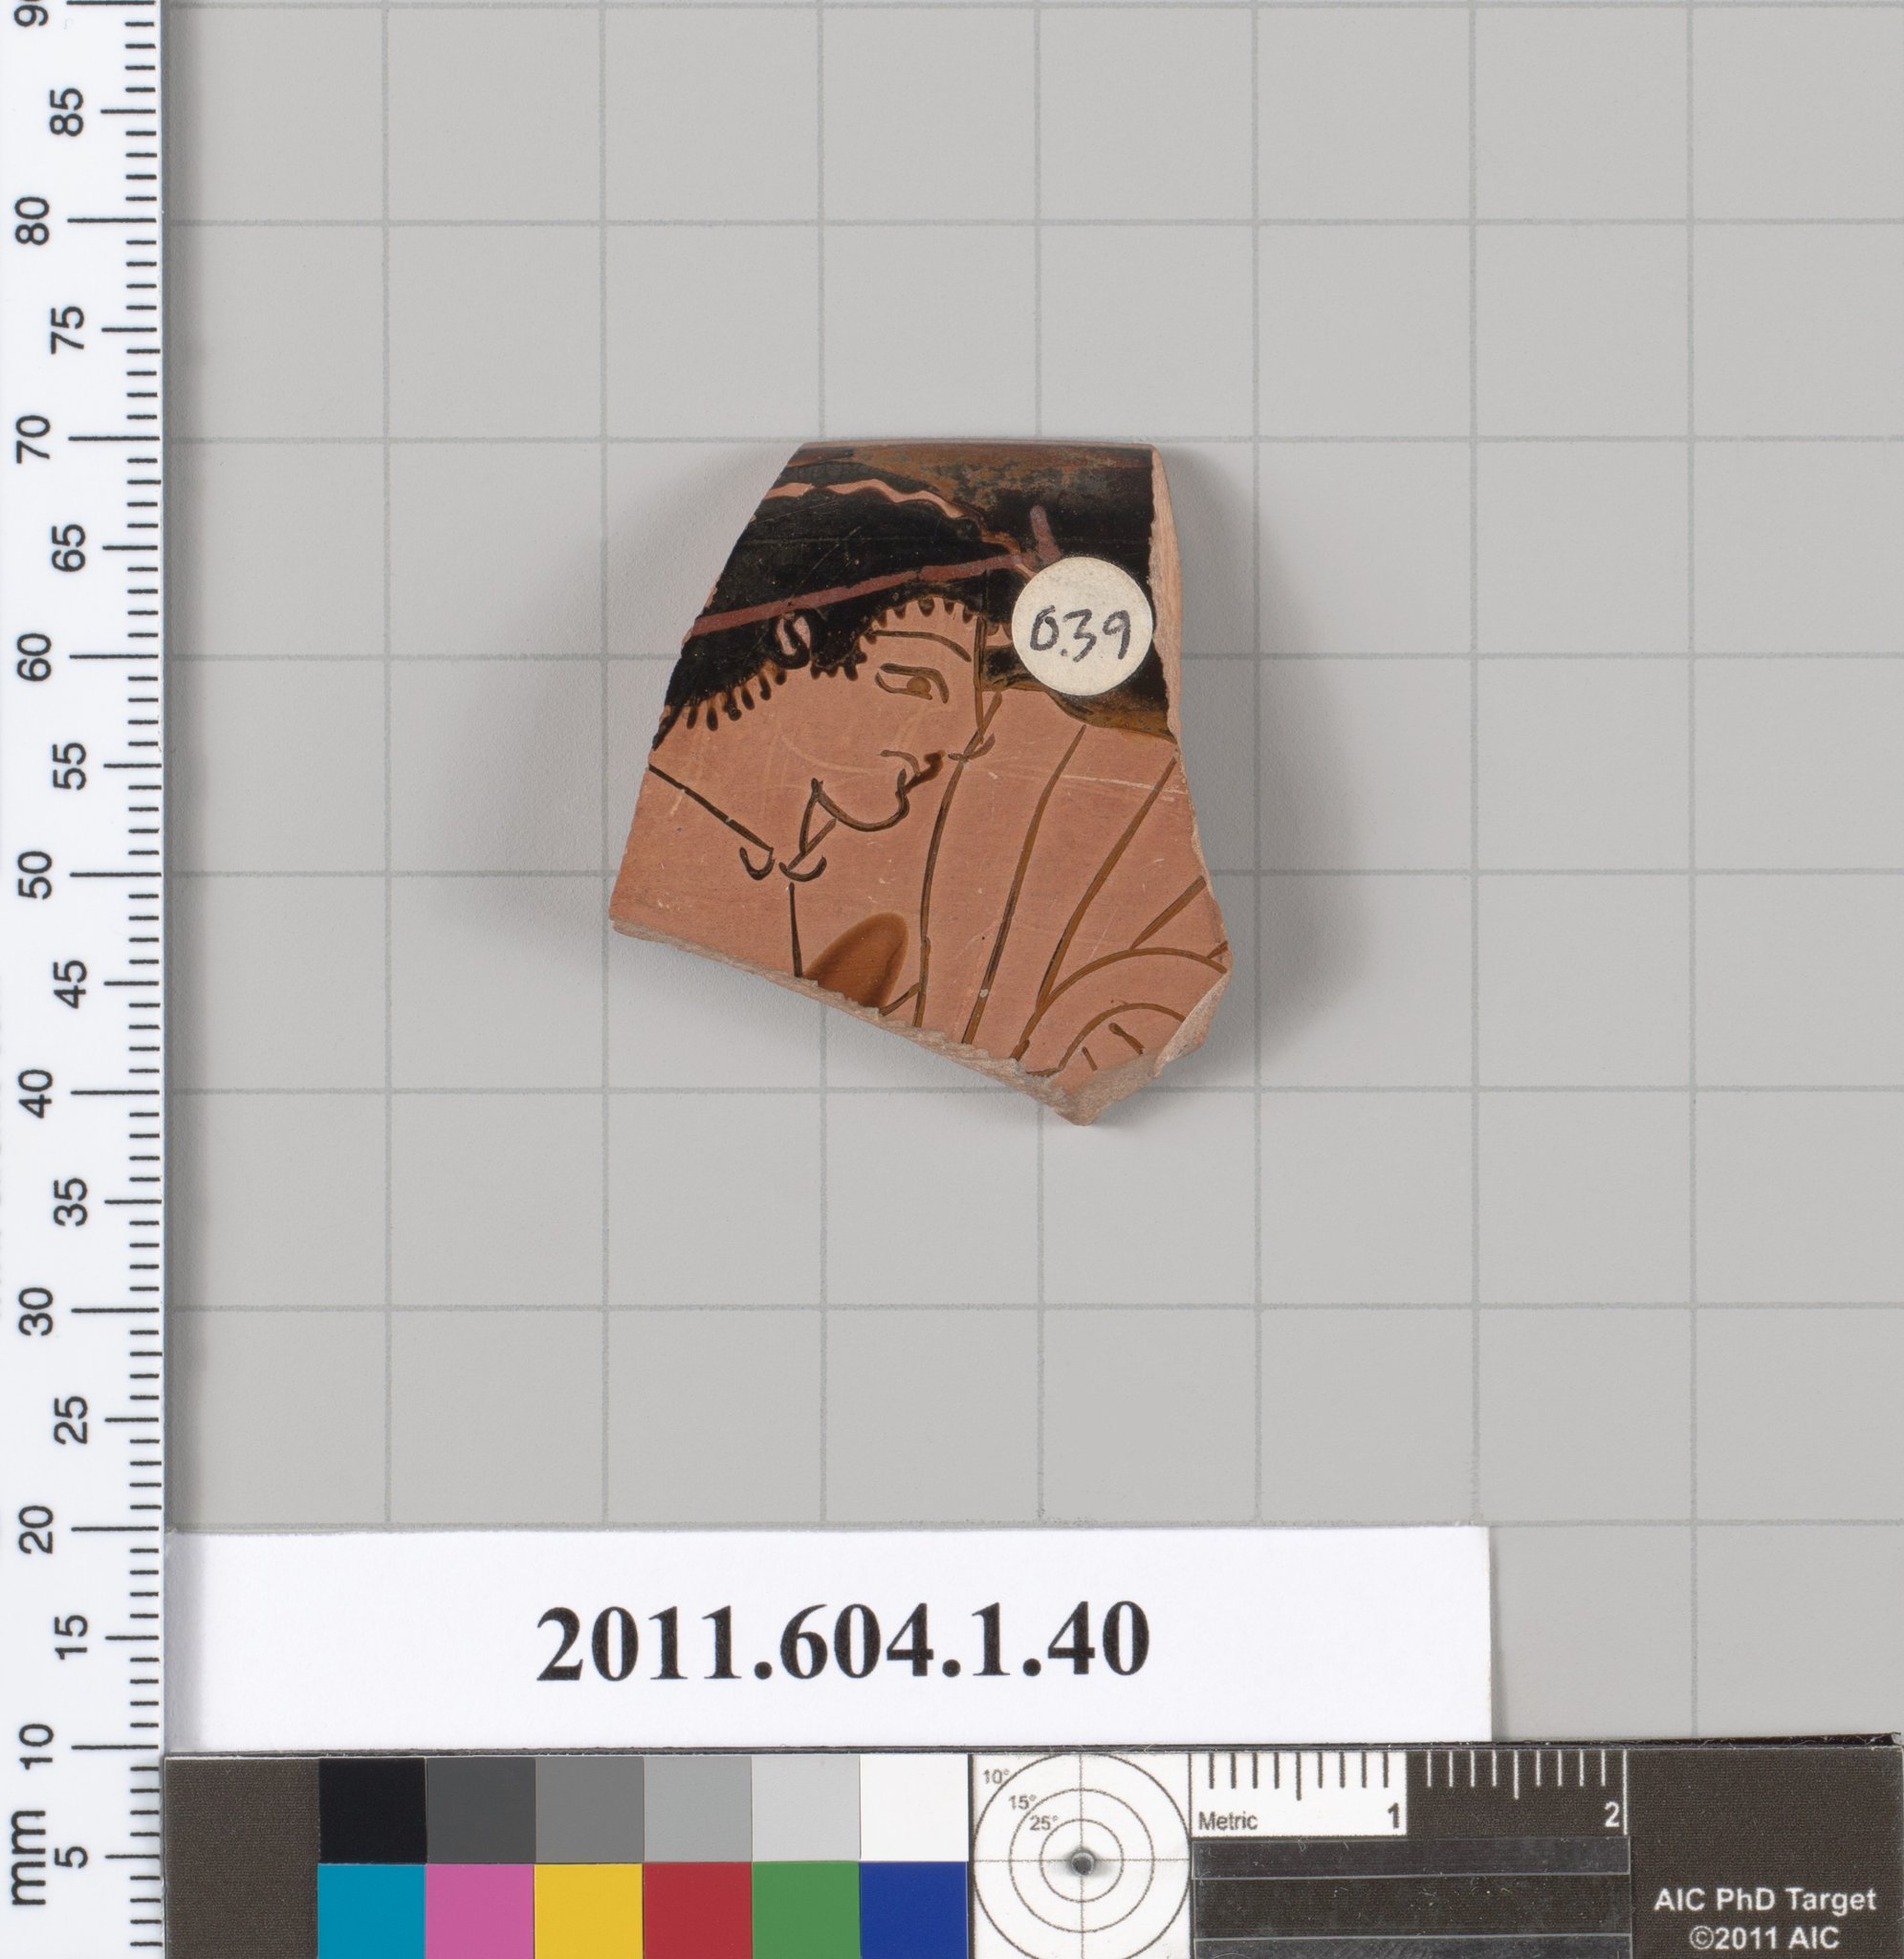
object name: kylix fragment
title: Terracotta rim fragment of a kylix (drinking cup)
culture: greek, attic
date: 480-470 BCE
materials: terracotta